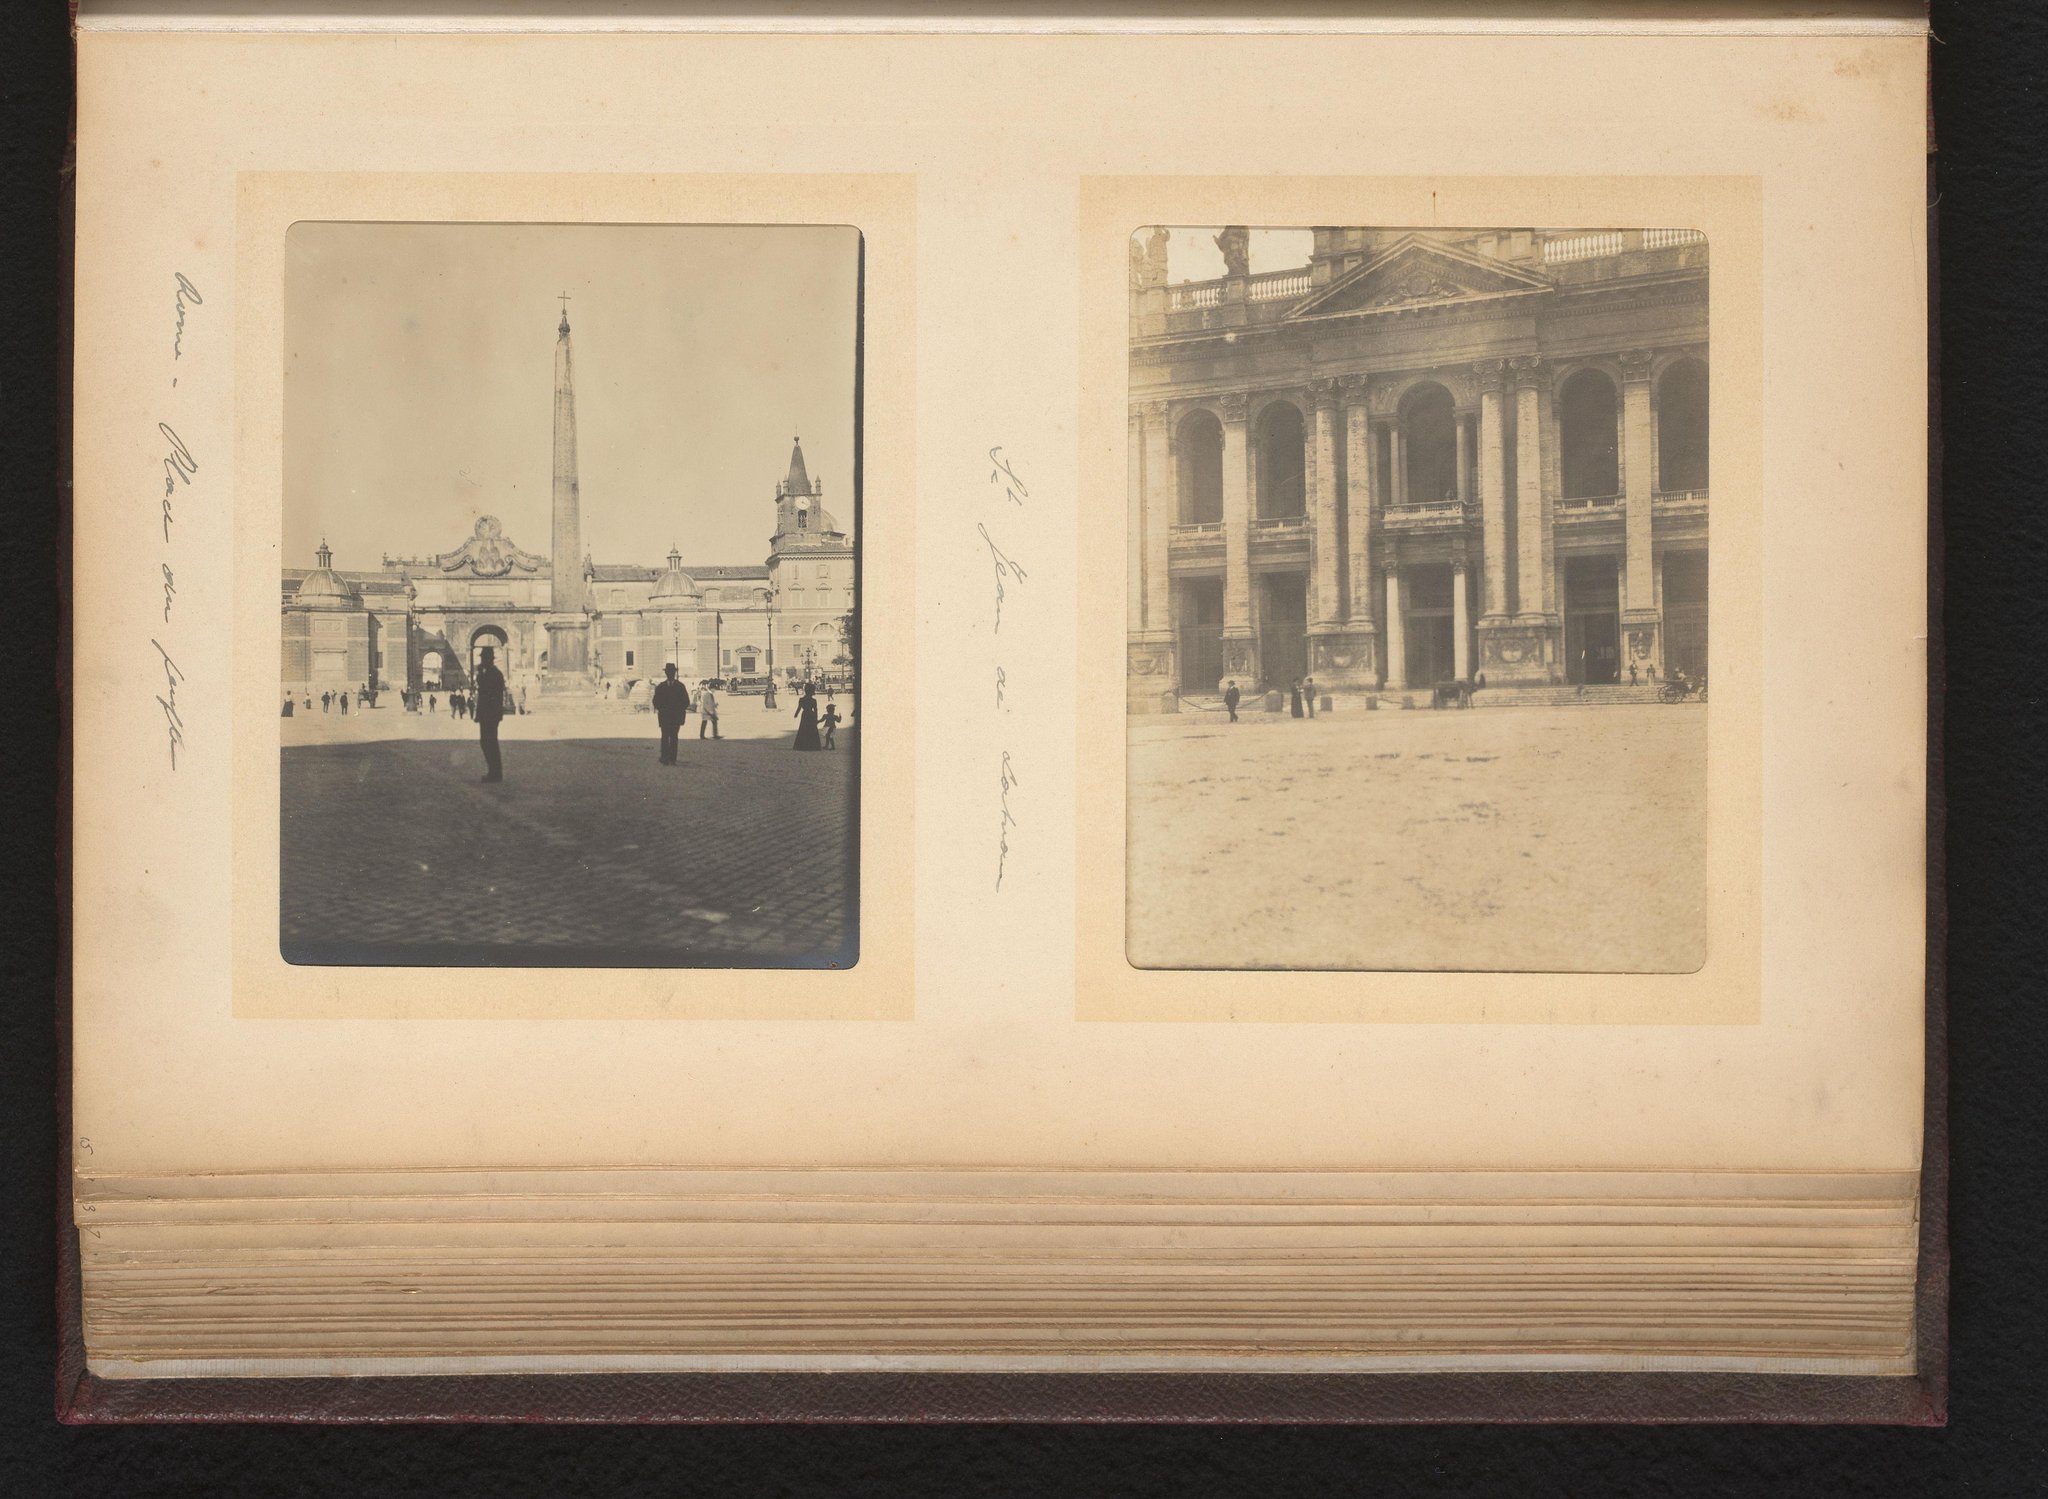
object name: album leaf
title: Sint-Jan van Lateranen en Piazza del Popolo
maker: Anonymous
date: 1895-1905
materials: cardboard, photographic support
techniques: gelatin silver print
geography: rome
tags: square, place, circus, etc., tourism, church (exterior), rome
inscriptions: inscription: ‘St. Jean de Latran / Rome Plein du peuple’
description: Albumblad met twee foto's in Rome. Onderdeel van een fotoalbum van een reis door Italië, ca. 1900.